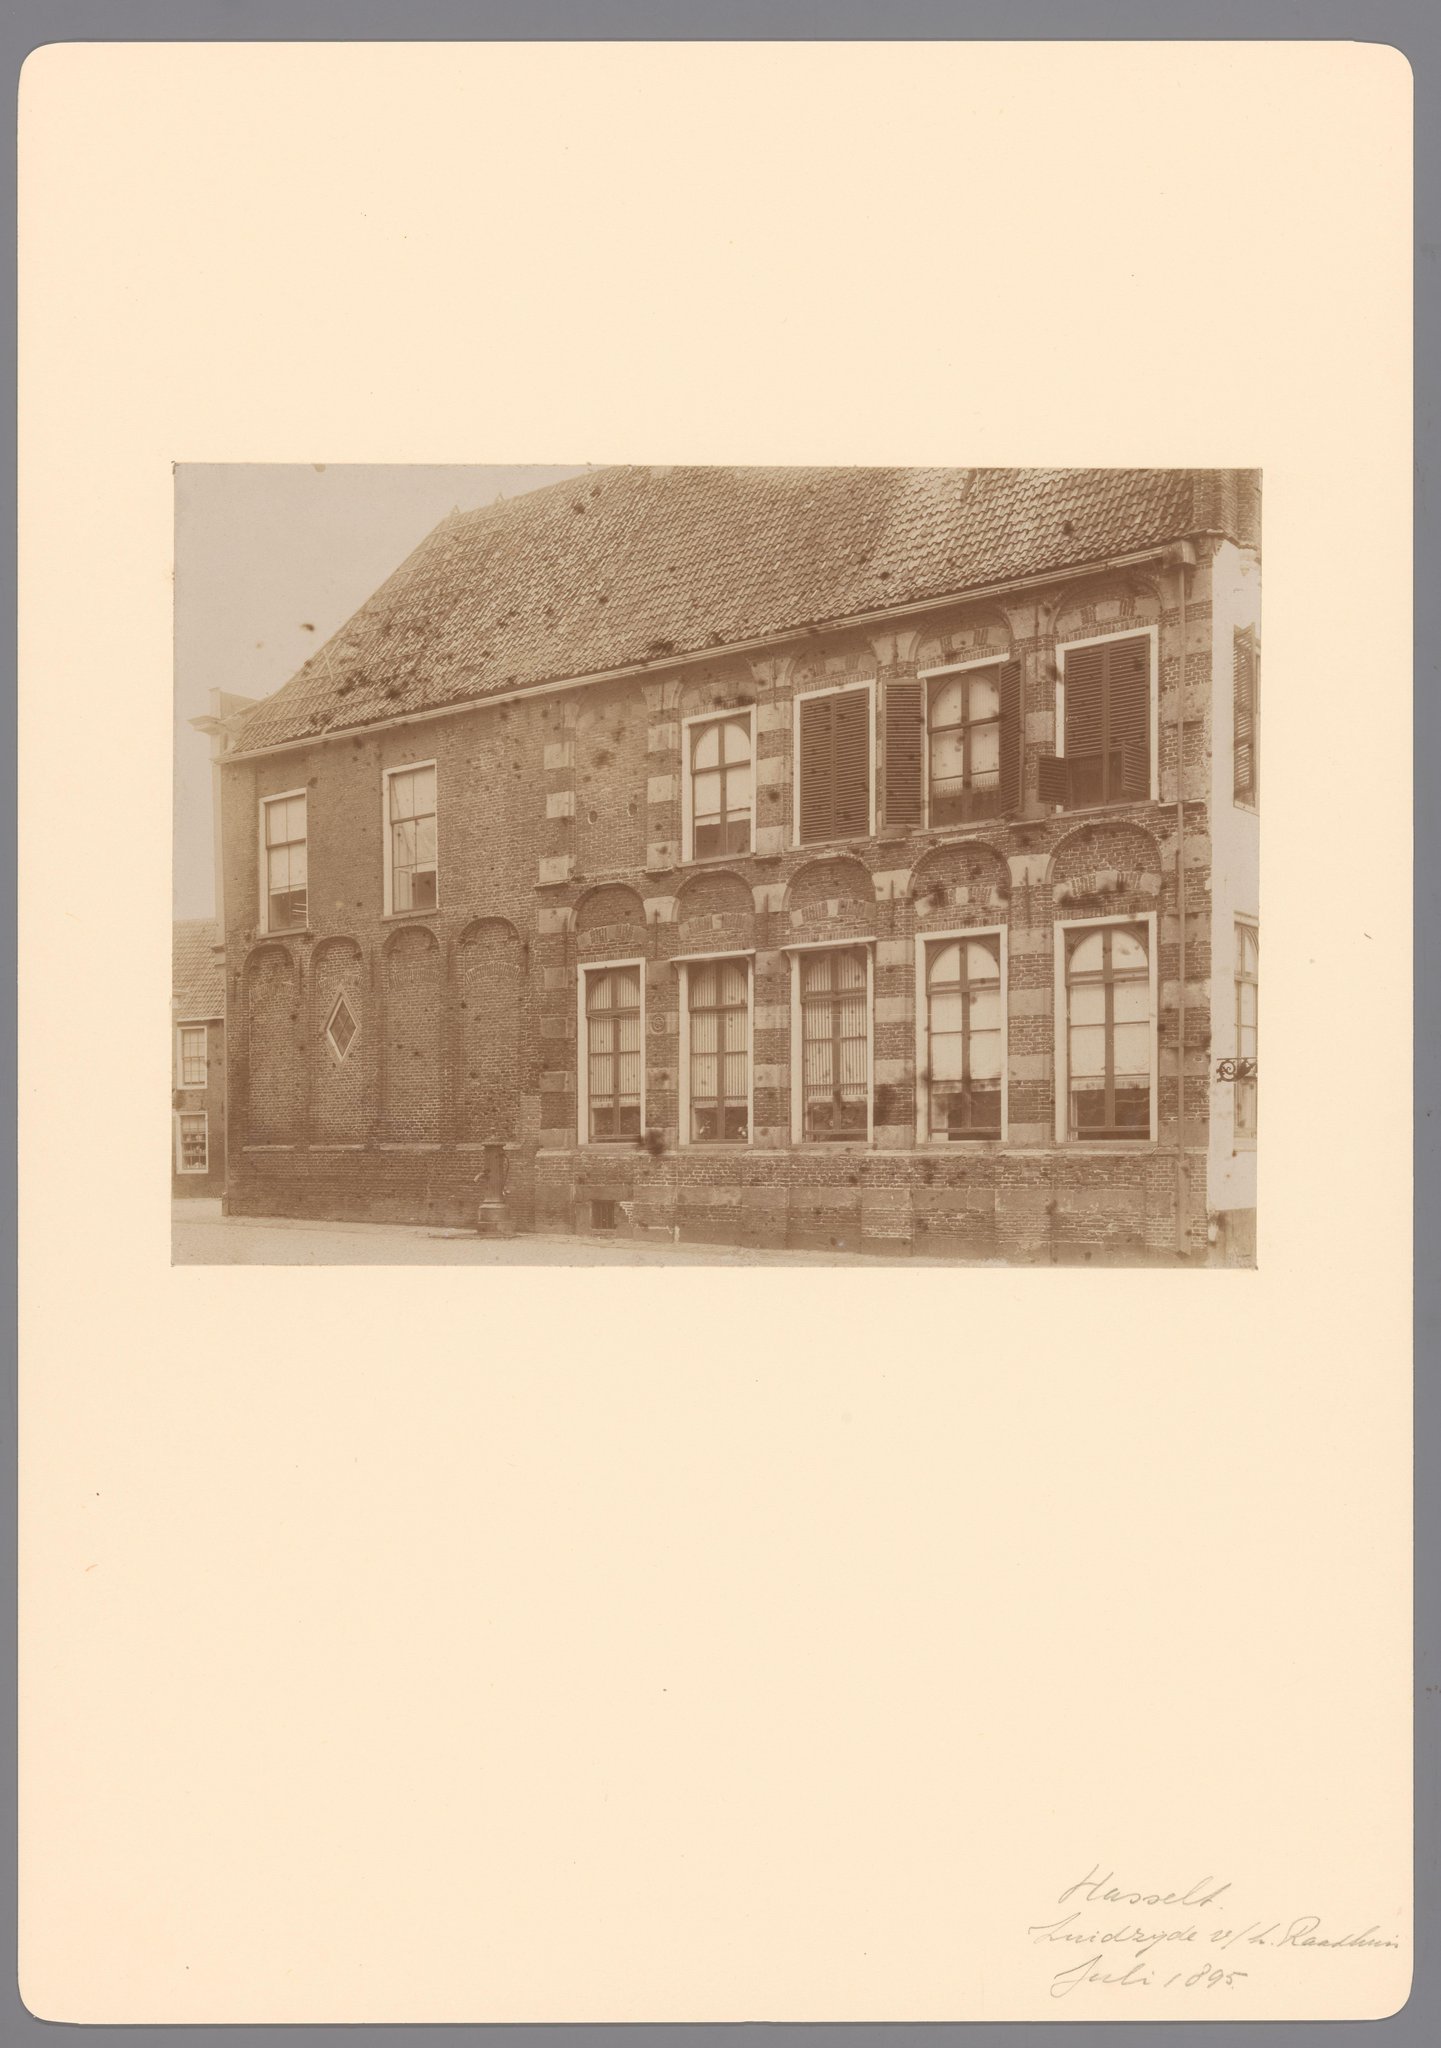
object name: photograph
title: Zuidzijde van het stadhuis te Hasselt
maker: anoniem (monumentenzorg)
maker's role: fotograaf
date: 1895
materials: cardboard, photographic support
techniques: collodion silver print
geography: hasselt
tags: townhall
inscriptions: annotation: ‘Hasselt/ Zuidzijde v/h Raadhuis/ Juli 1895’